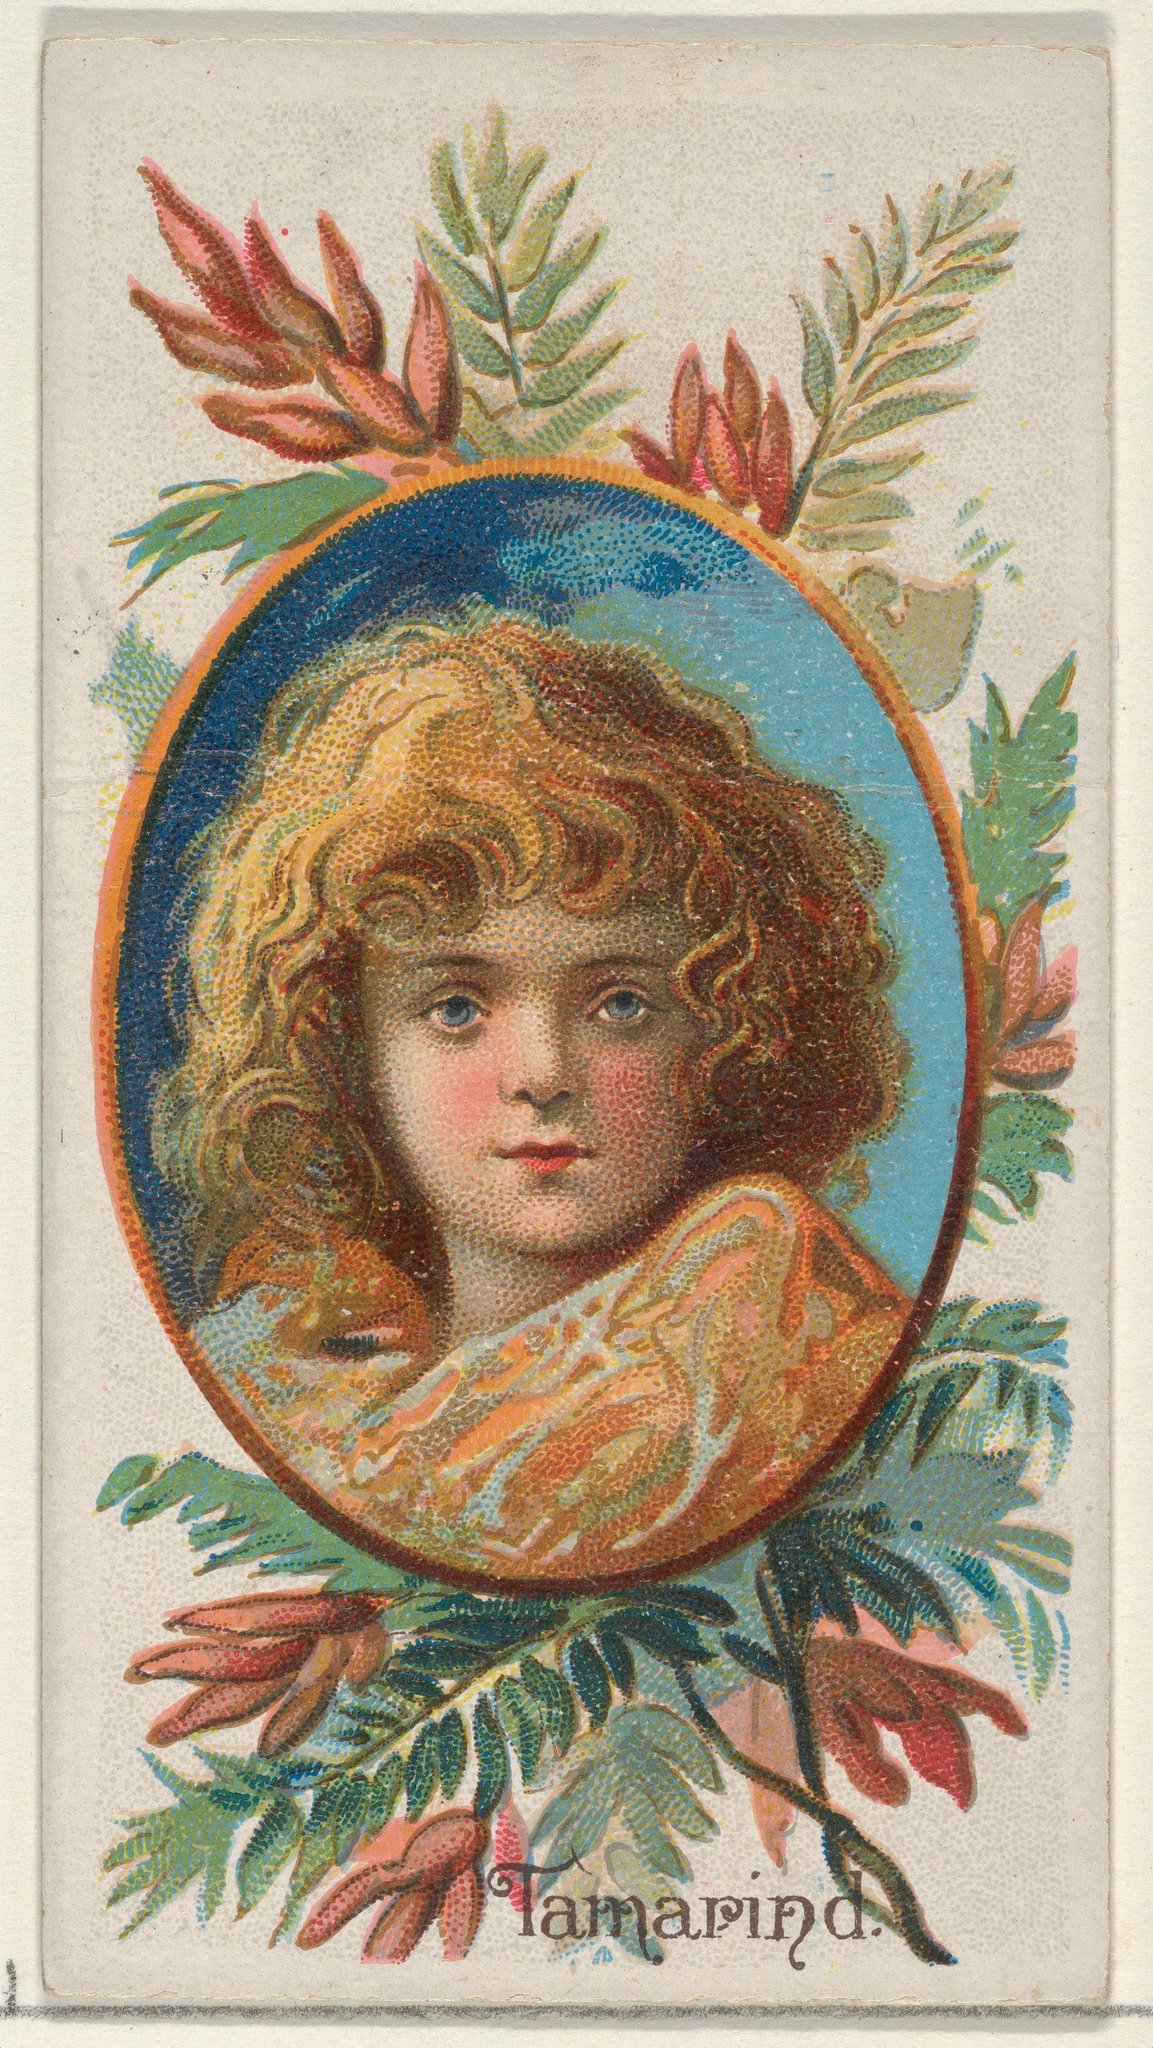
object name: print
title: Tamarind, from the Fruits series (N12) for Allen & Ginter Cigarettes Brands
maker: allen & ginter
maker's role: publisher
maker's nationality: american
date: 1891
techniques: color lithograph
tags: girls,leaves